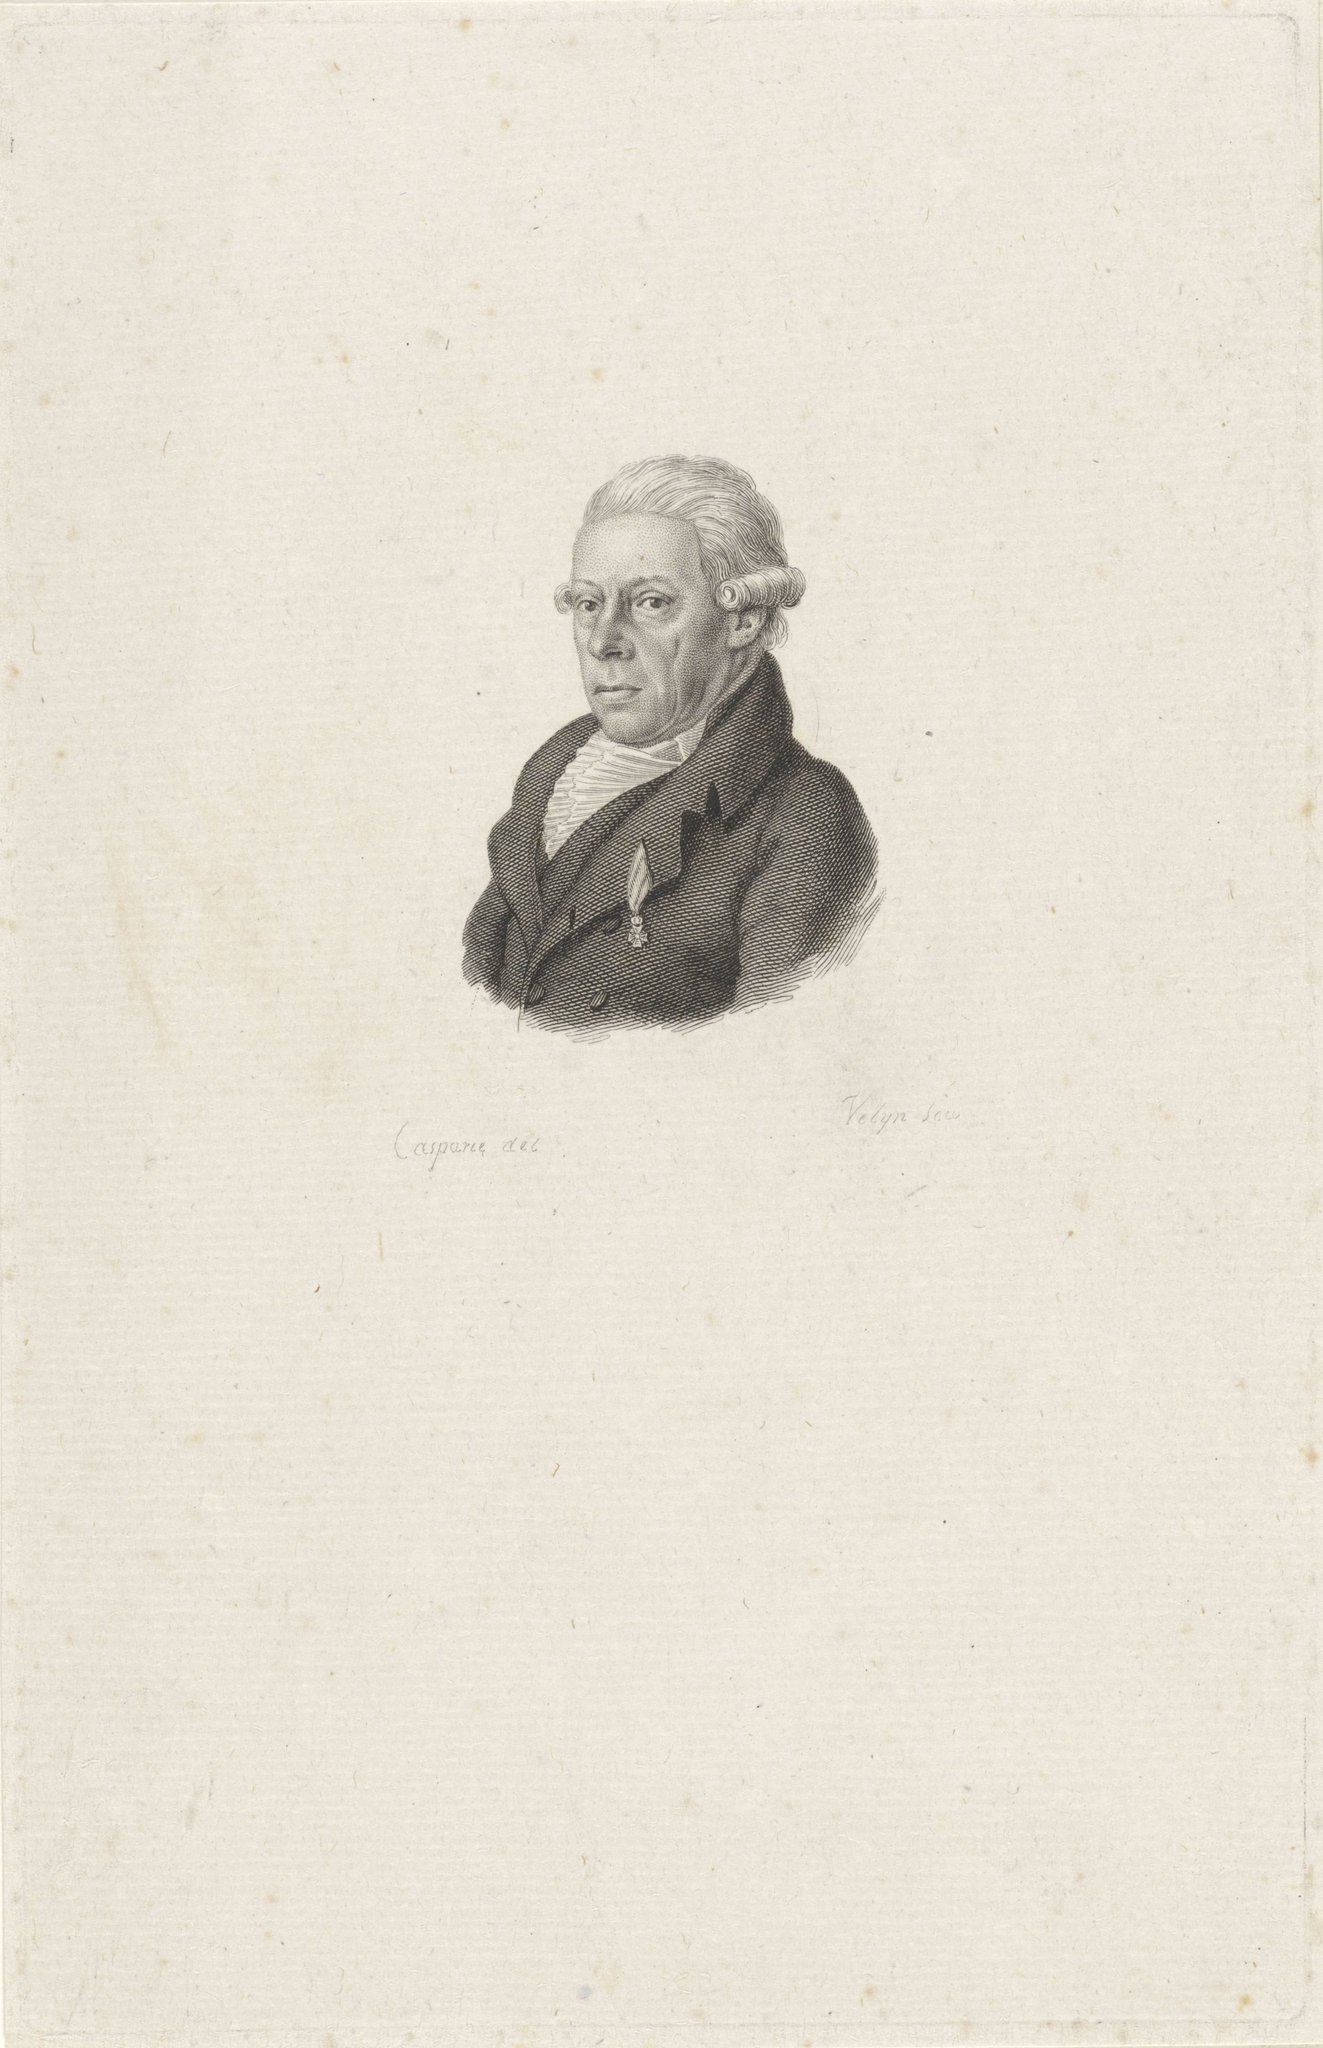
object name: print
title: Portret van Rijnvis Feith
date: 1797-1804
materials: paper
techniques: engraving, etching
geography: netherlands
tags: rhijnvis feith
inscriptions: collector's mark: Lugt 2228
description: Portret van de dichter en advocaat Rhijnvis Feith.